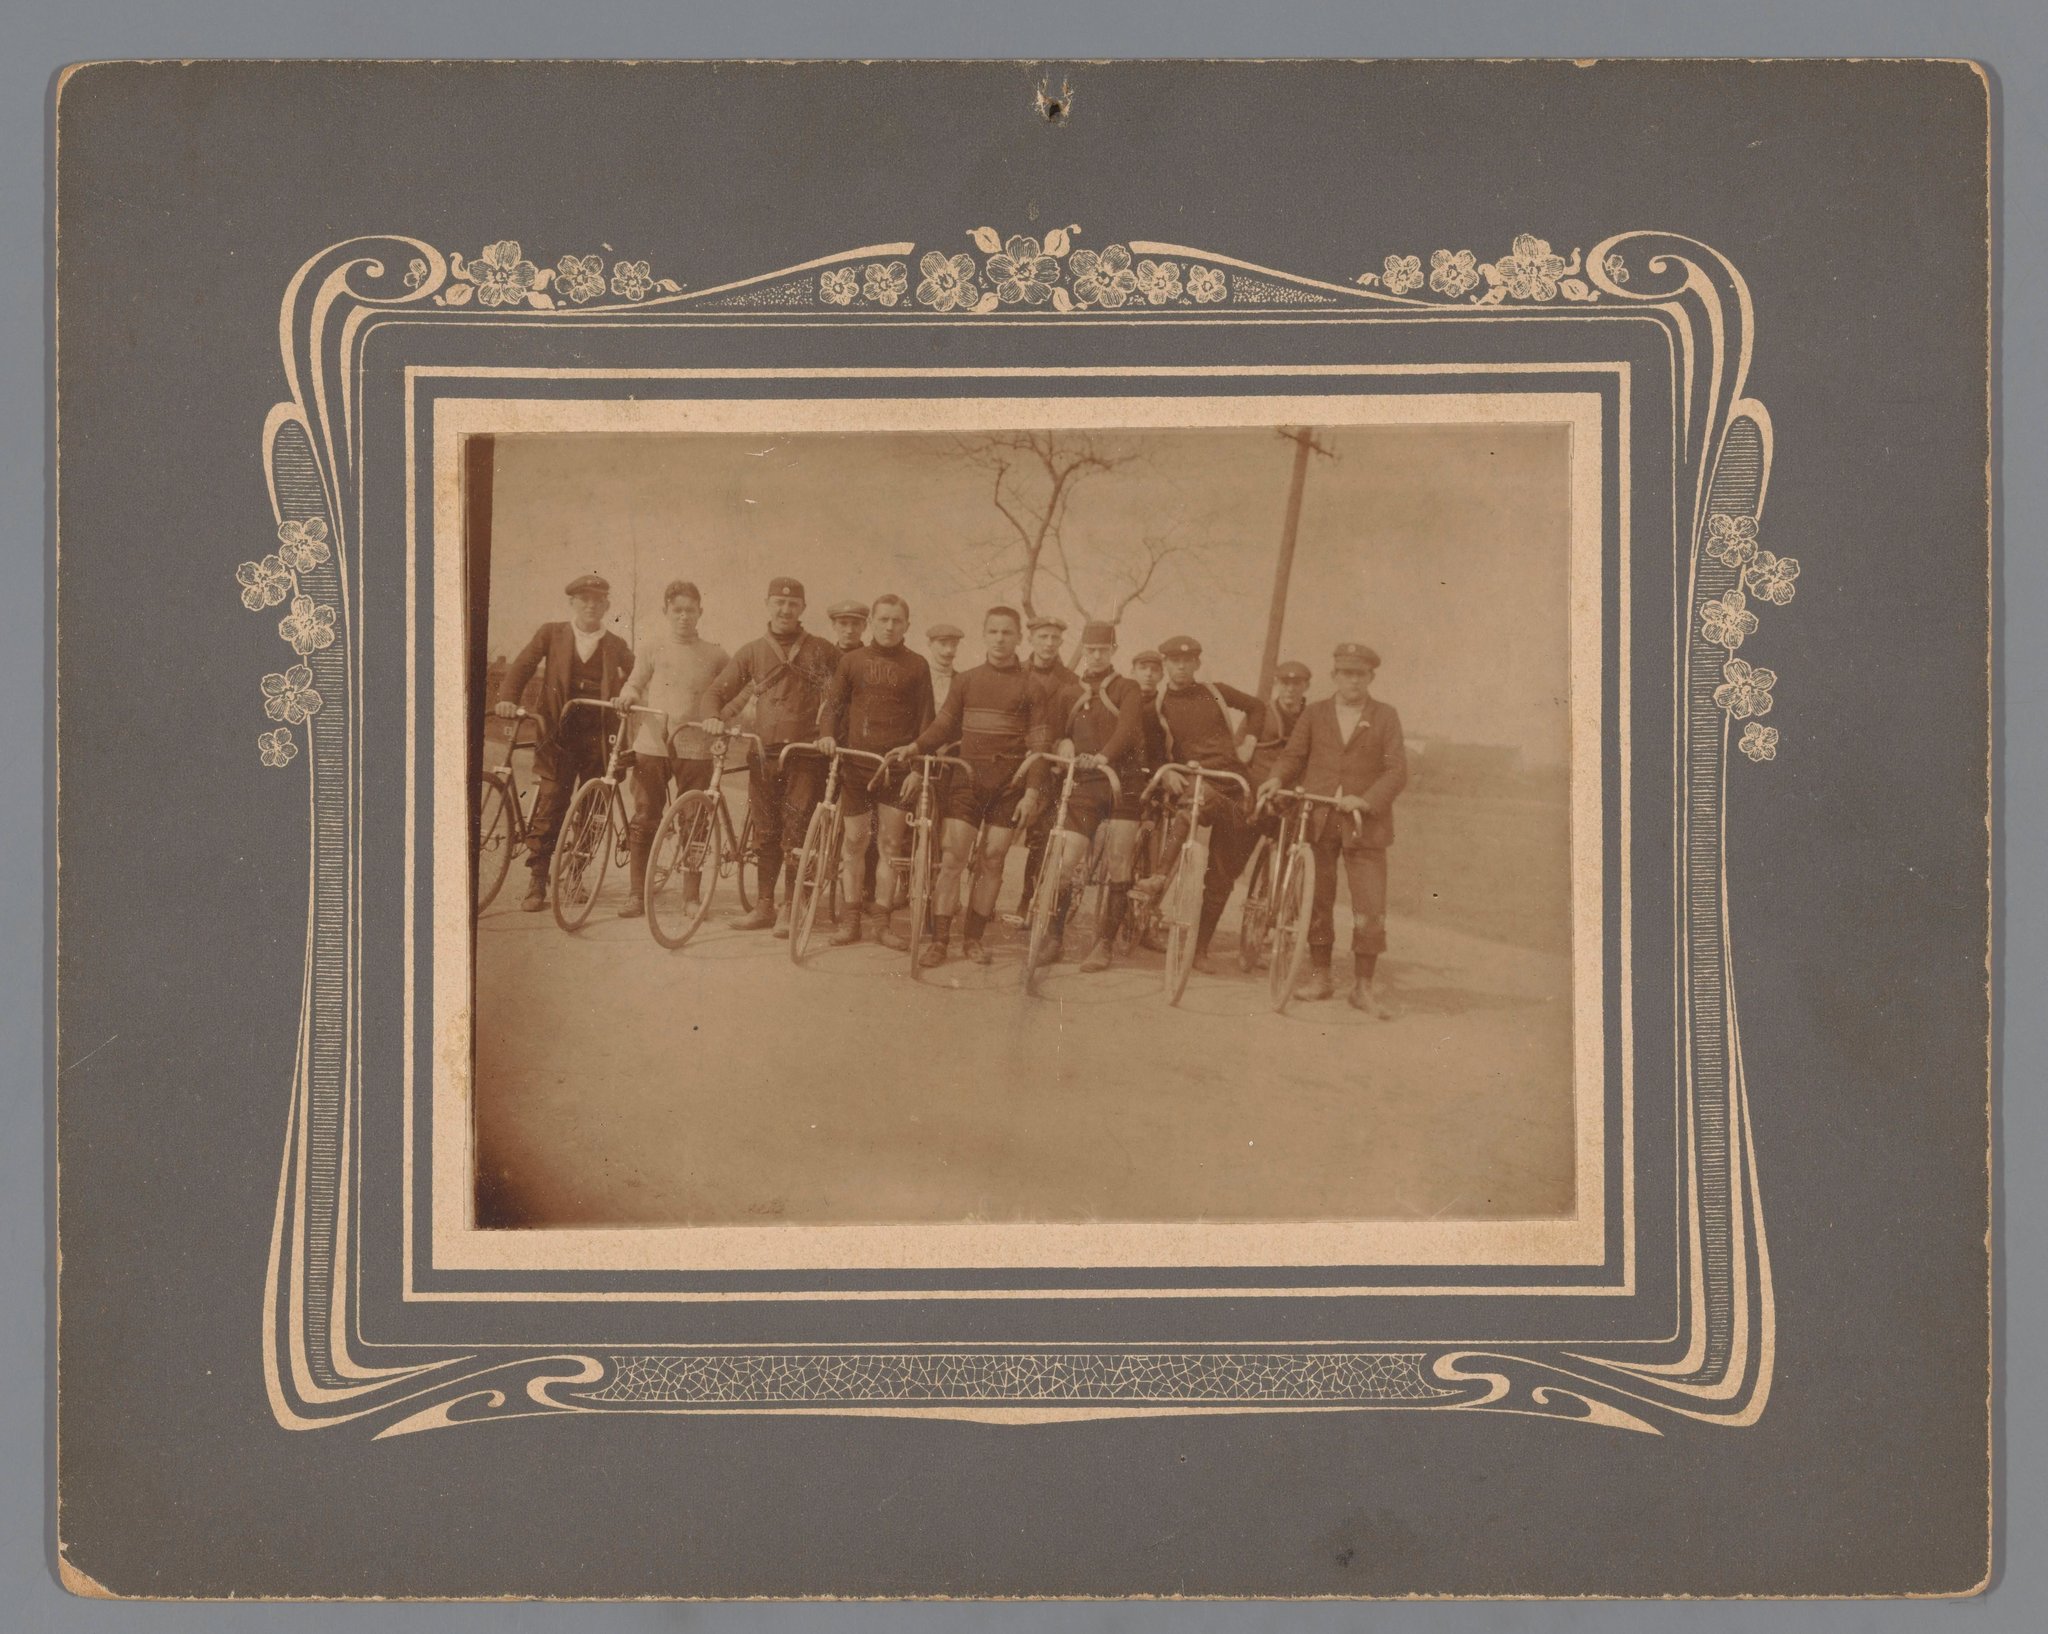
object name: photograph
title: Groepsportret van onbekende mannen met fietsen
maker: Anonymous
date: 1910-1930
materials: cardboard, photographic support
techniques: gelatin silver print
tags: bicycle, anonymous historical persons portrayed in a group, in a group-portrait